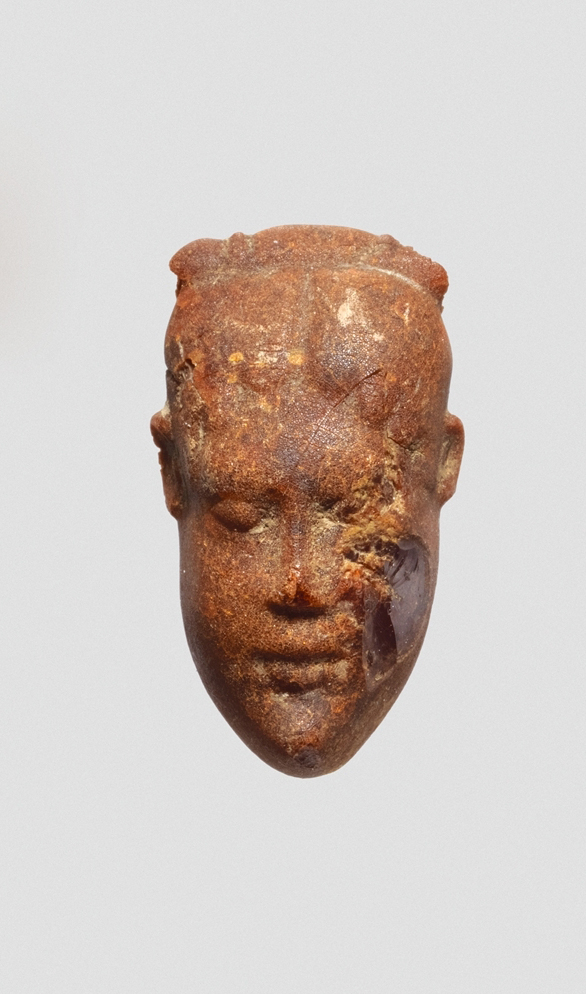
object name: head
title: Pendant: head of a woman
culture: etruscan-campanian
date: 500-401 BCE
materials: amber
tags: heads,women